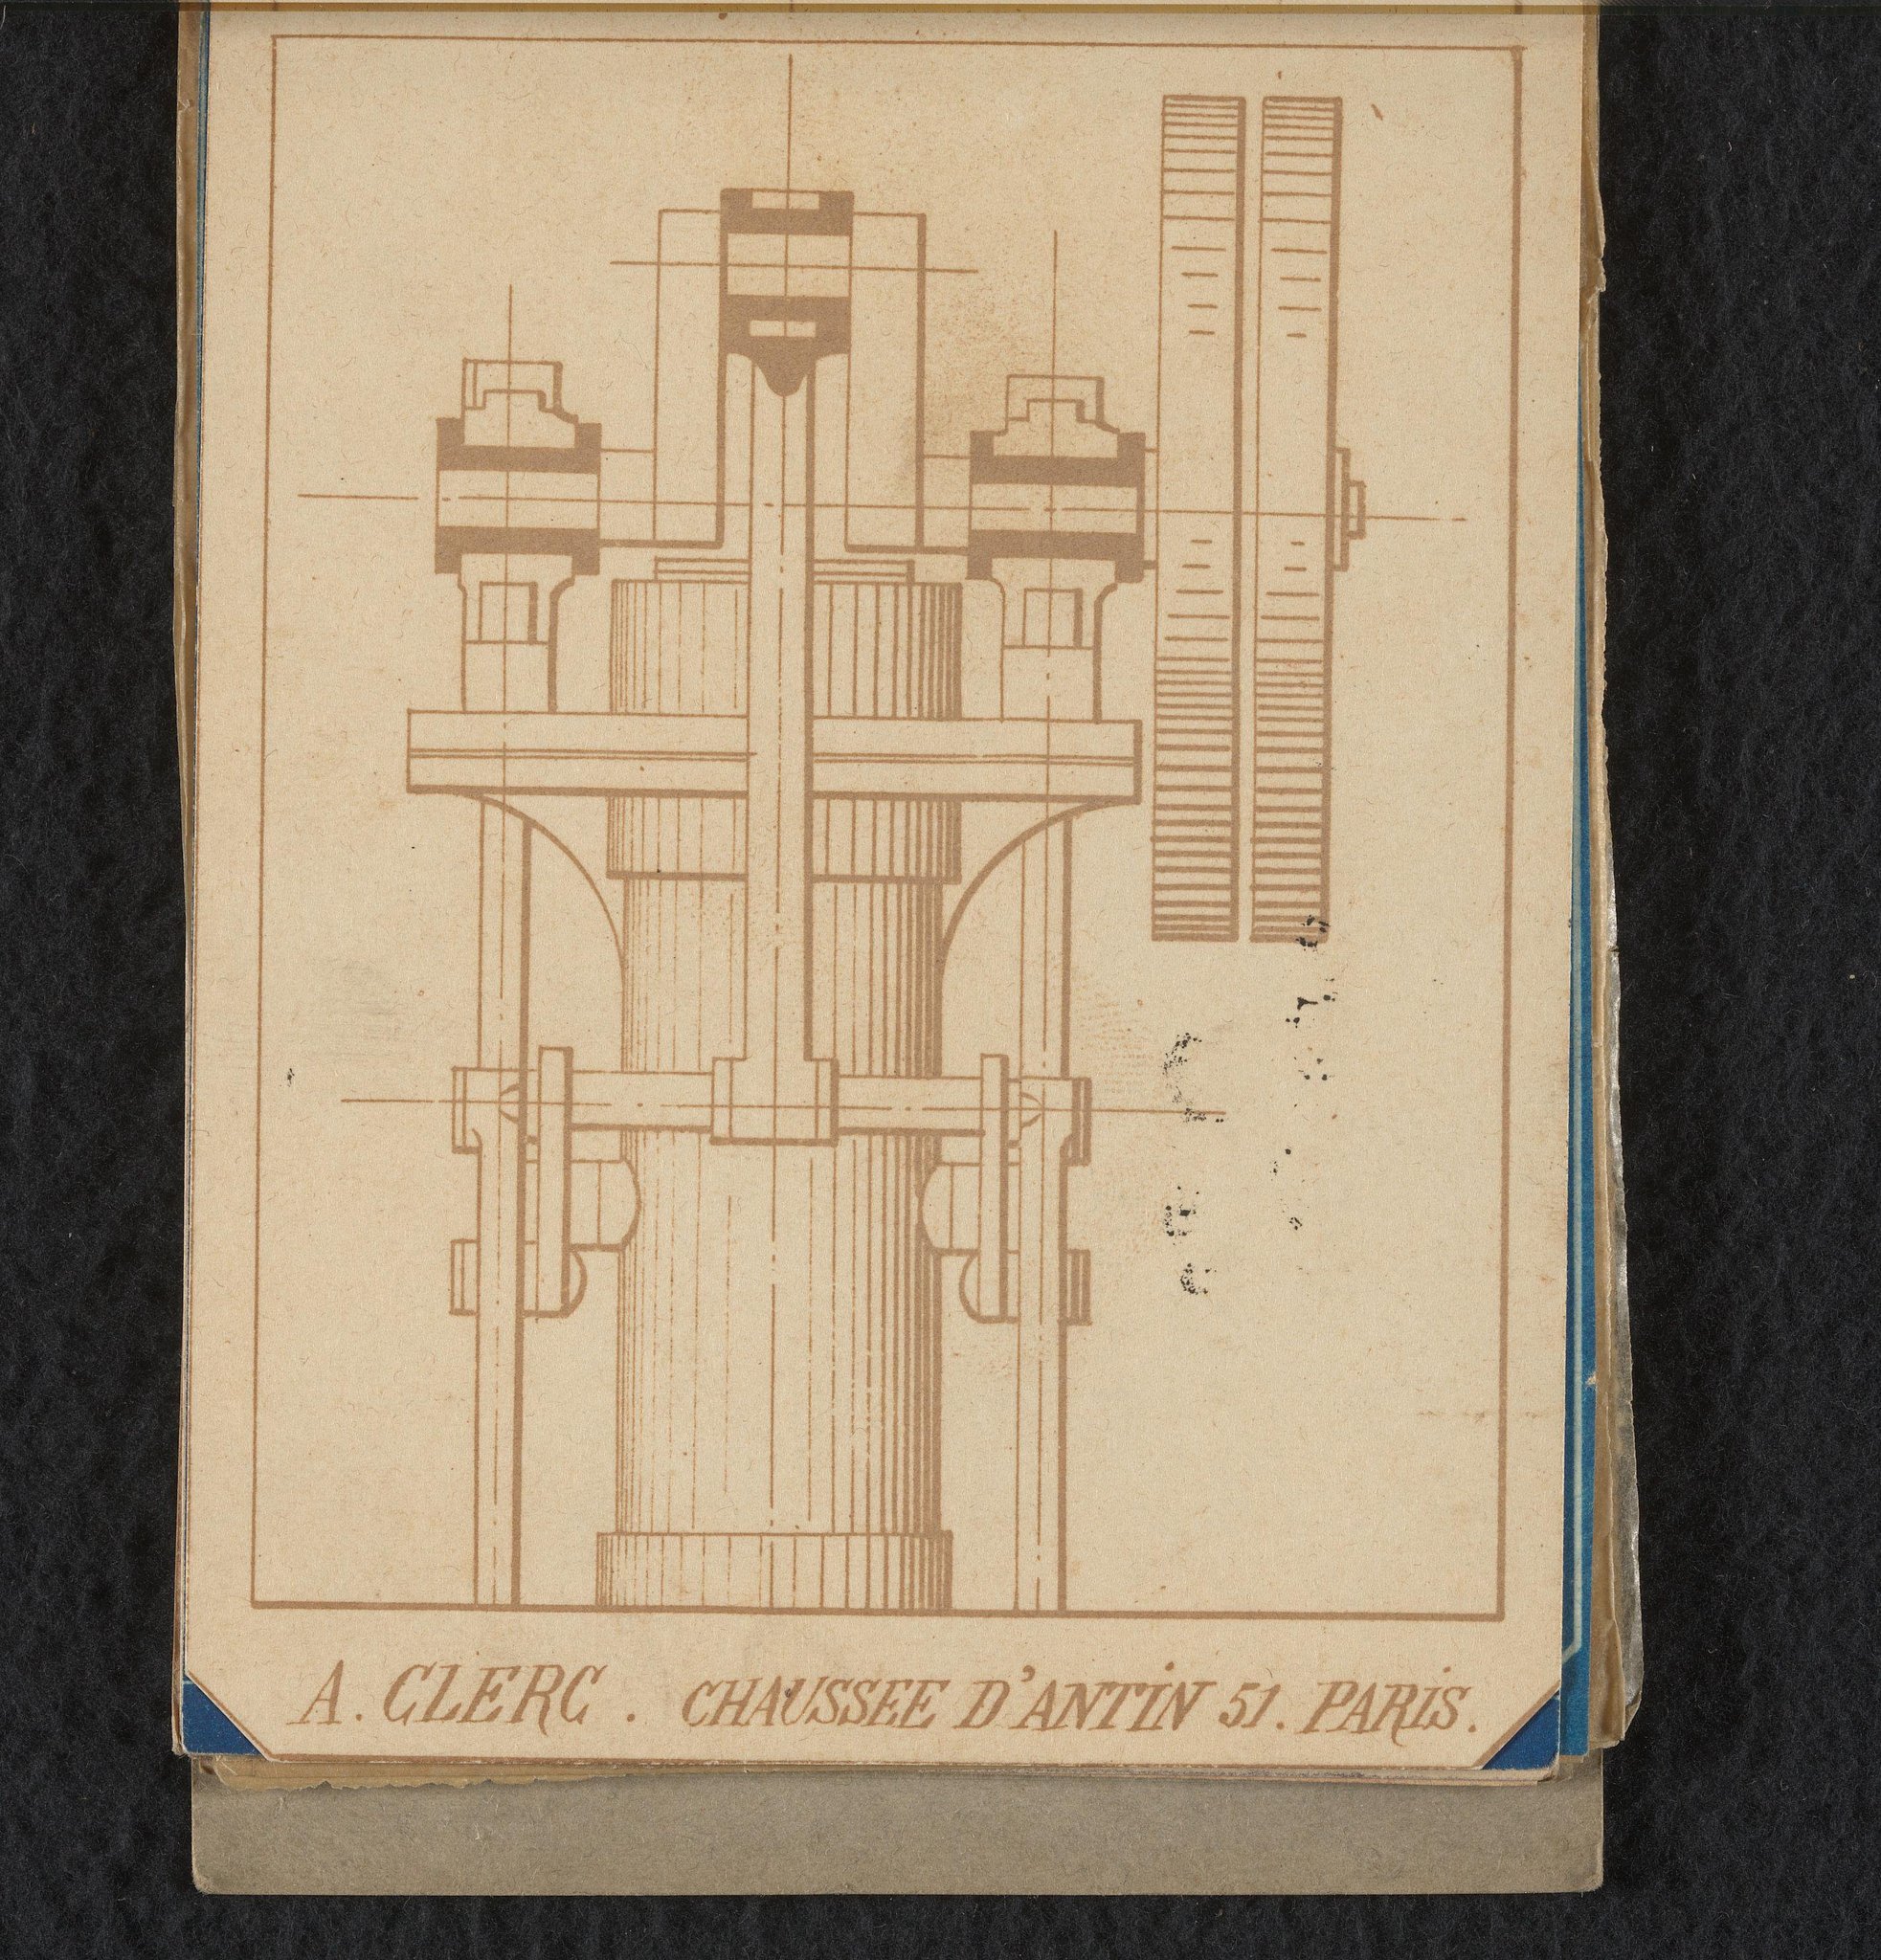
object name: photograph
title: Fotoreproductie van een technische tekening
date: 1905-1910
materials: paper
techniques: iron processes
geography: paris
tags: parts of machines, drawing (industrial process), paris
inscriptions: inscription: ‘HELIO trait sur fond blanc / No 600 simple lavage á l'eau / No 60 avec bain de gallate / TARIF PAGE 2’, inscription: ‘Téléphone - 214-09.’, address: ‘A. Clerc. Chaussee d'Antin 51. Paris.’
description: Foto op eerste ongenummerde pagina na voorplat.